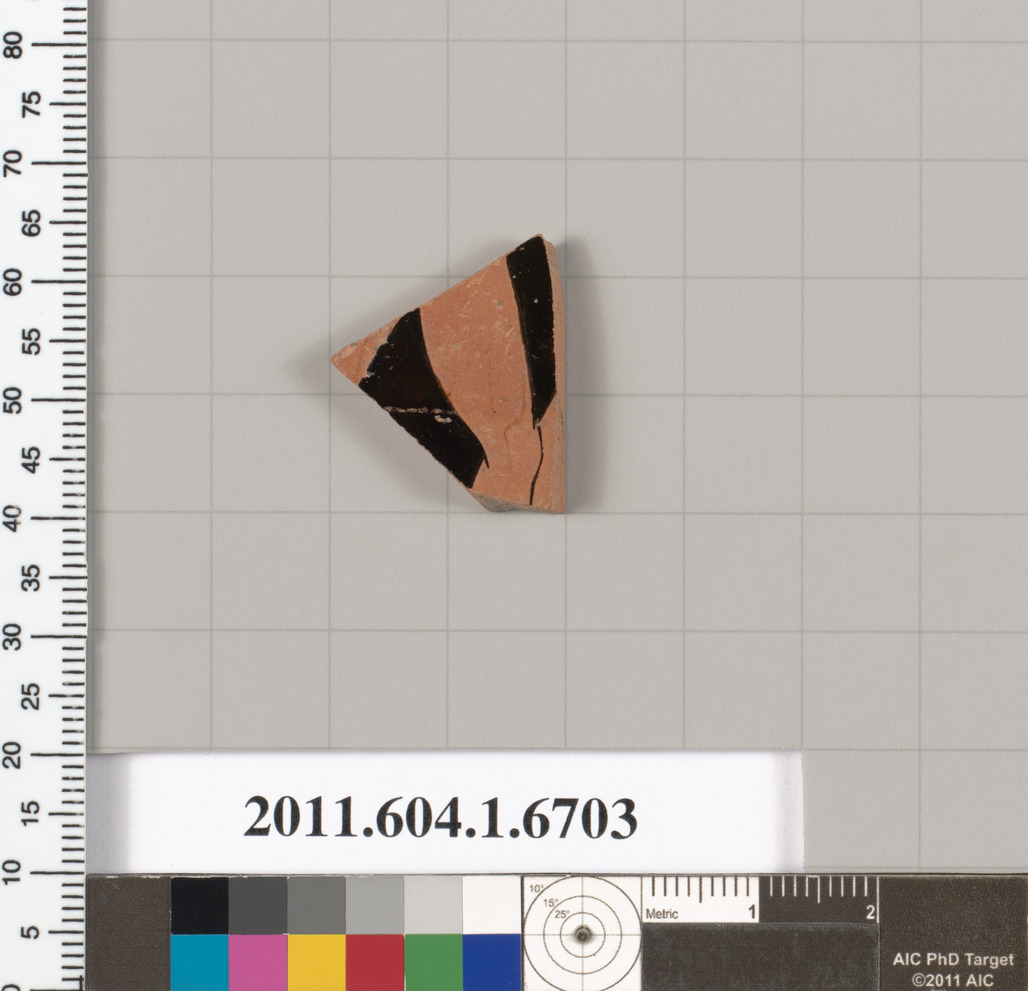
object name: kylix fragment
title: Terracotta fragment of a kylix (drinking cup)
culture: greek, attic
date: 490-470 BCE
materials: terracotta